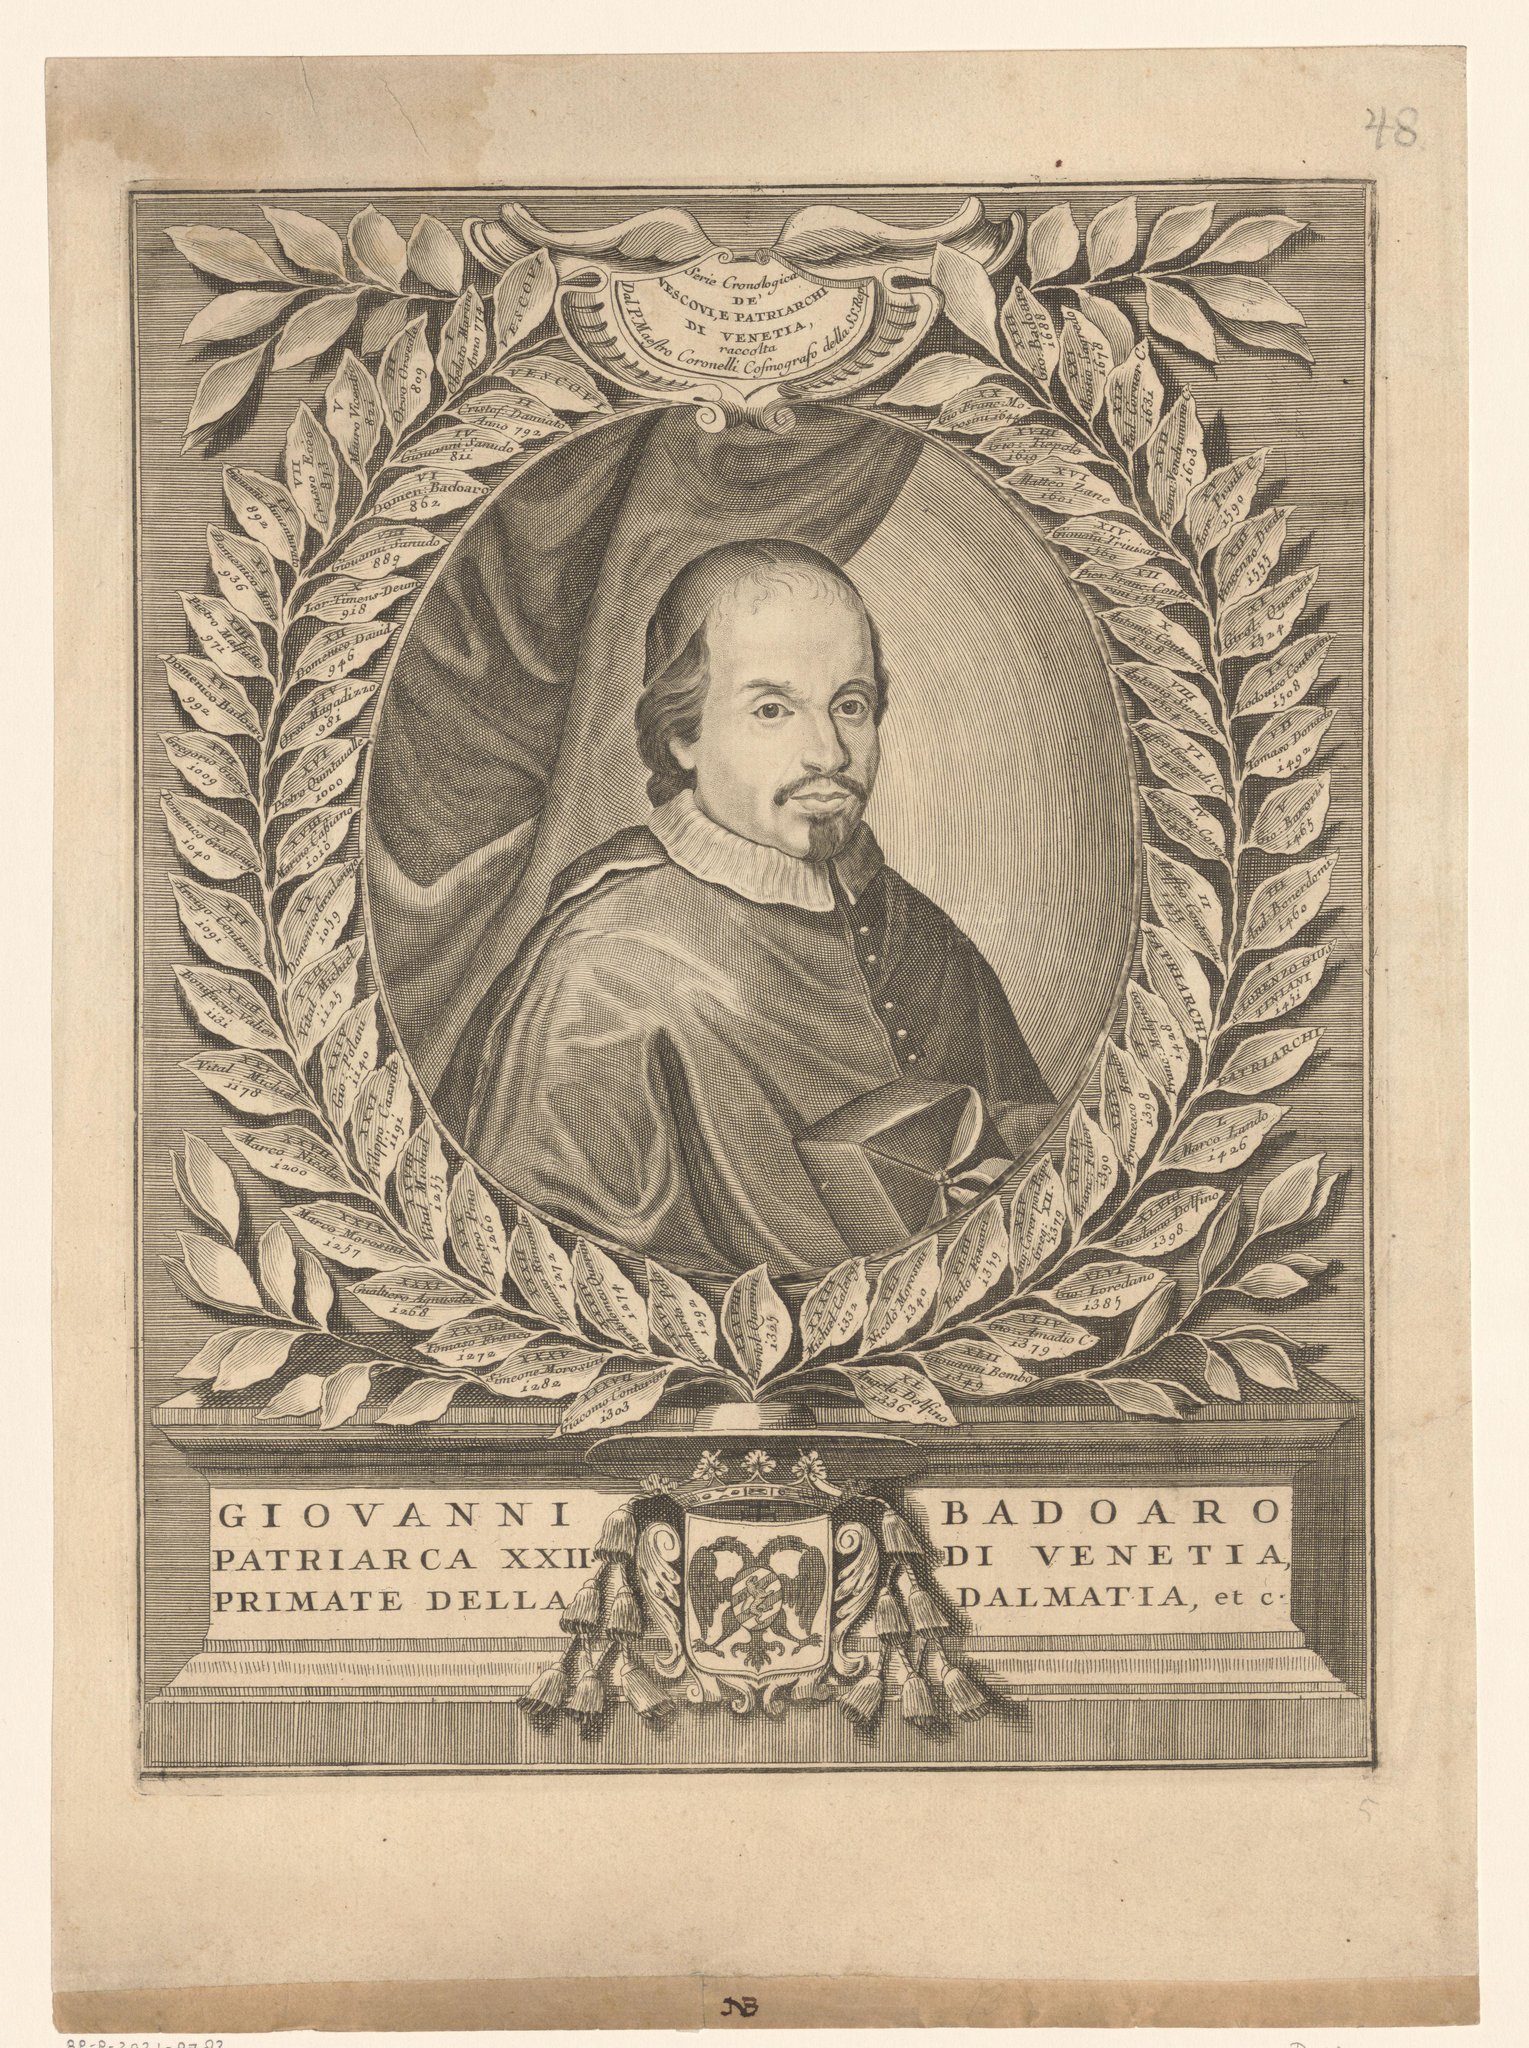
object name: print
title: Bisschoppen en patriarchen van Venetië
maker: vicenzo maria coronelli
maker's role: print maker, publisher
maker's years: 1650-1718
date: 1688-1718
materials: paper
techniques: engraving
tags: cardinal, historical persons, armorial bearing, heraldry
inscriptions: collector's mark: Lugt 2228